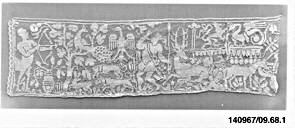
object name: panel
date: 1600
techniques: embroidery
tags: animals,bow and arrow,men,trees